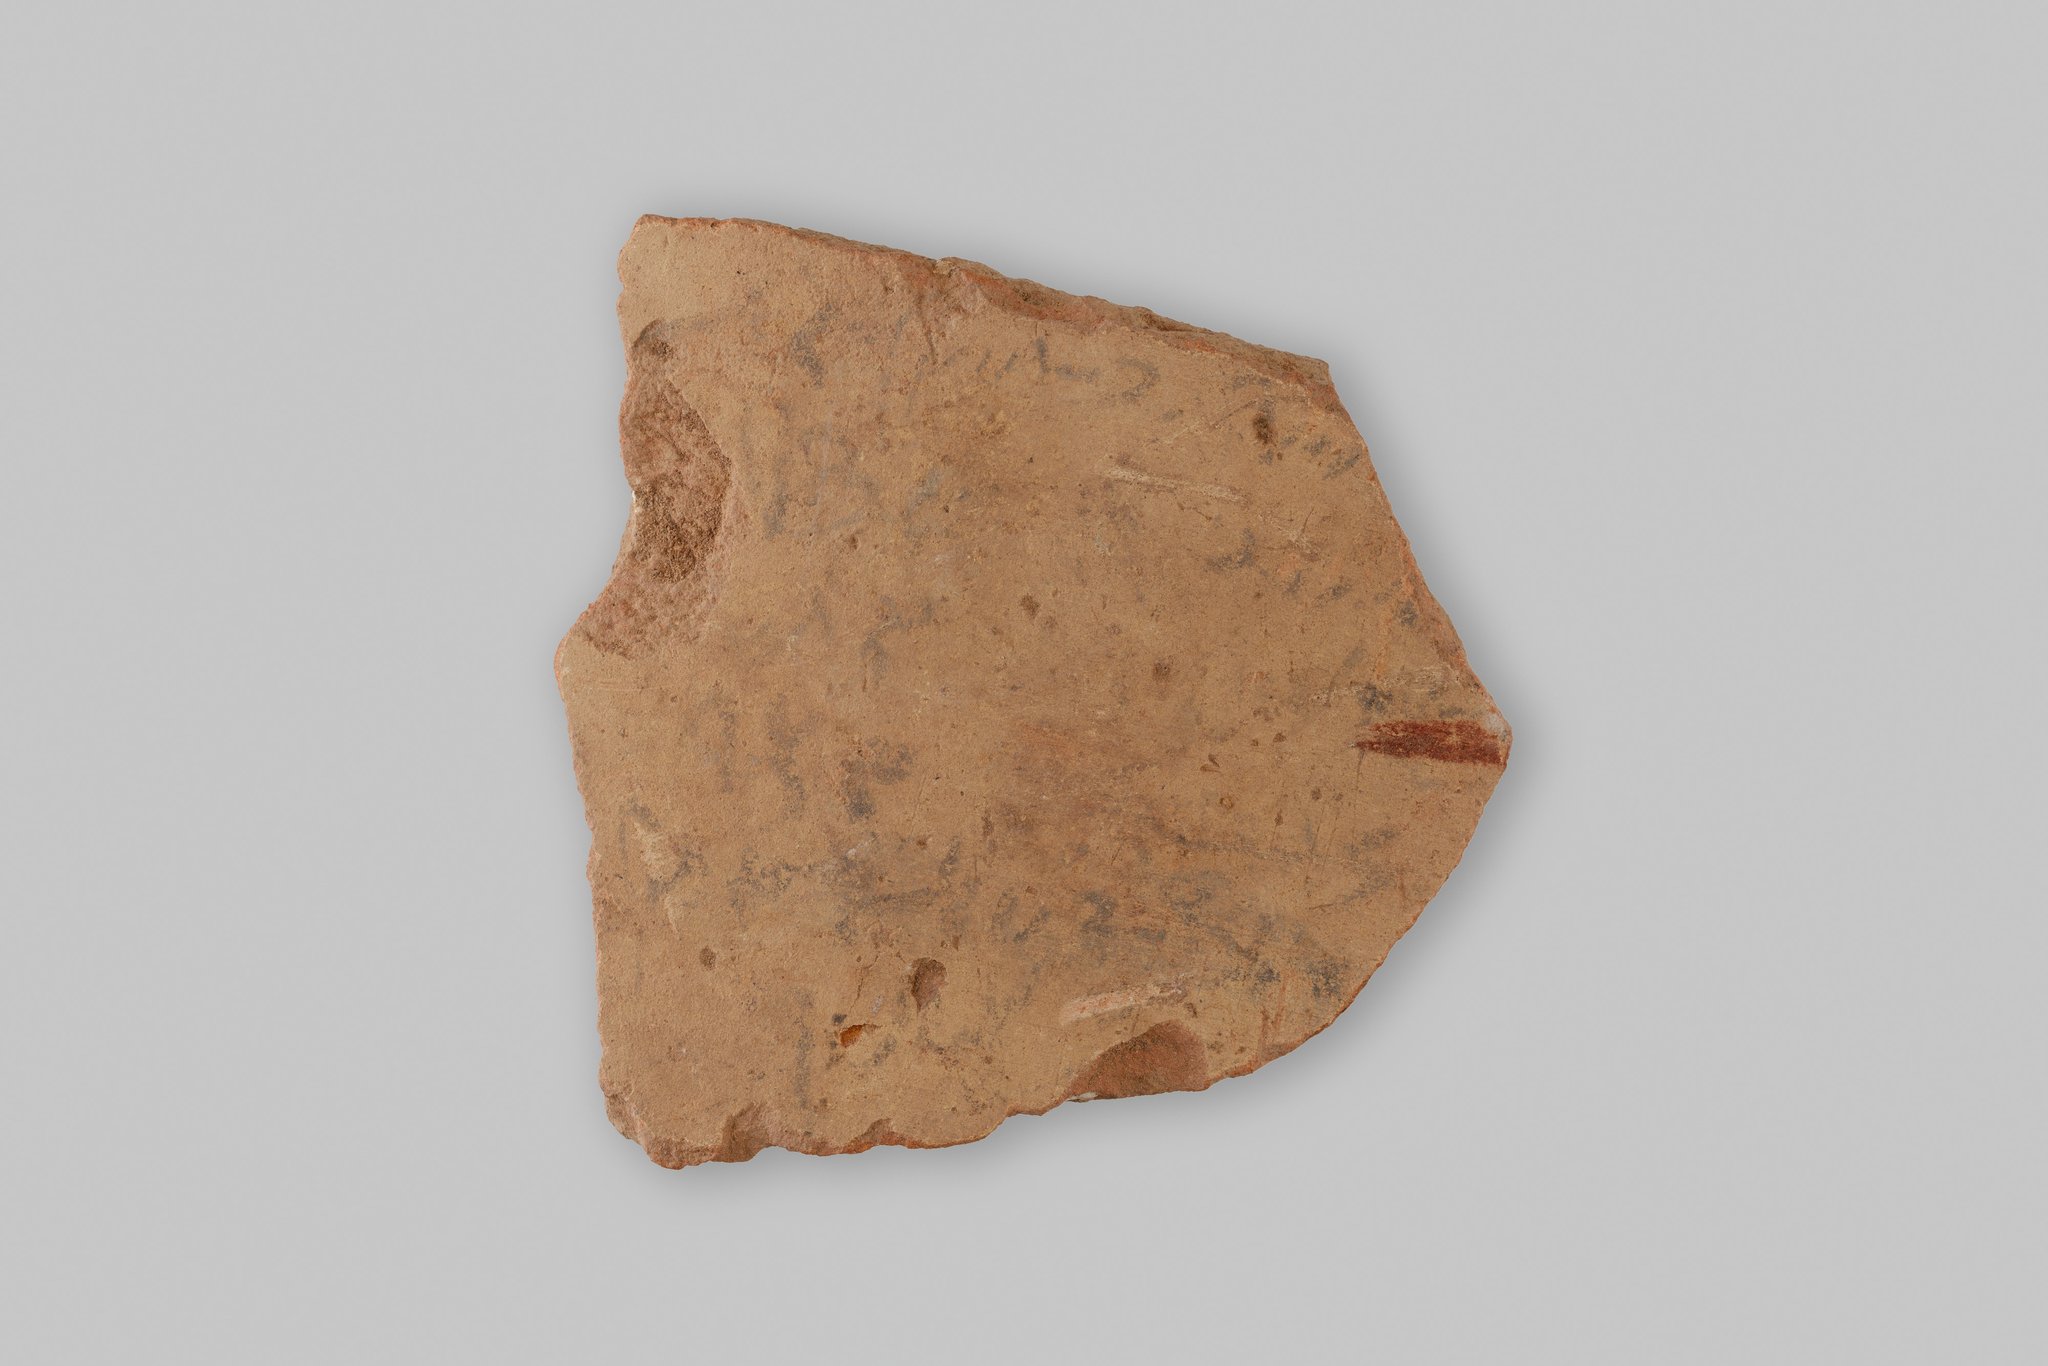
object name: ostracon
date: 400-30 BCE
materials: ink, pottery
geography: egypt